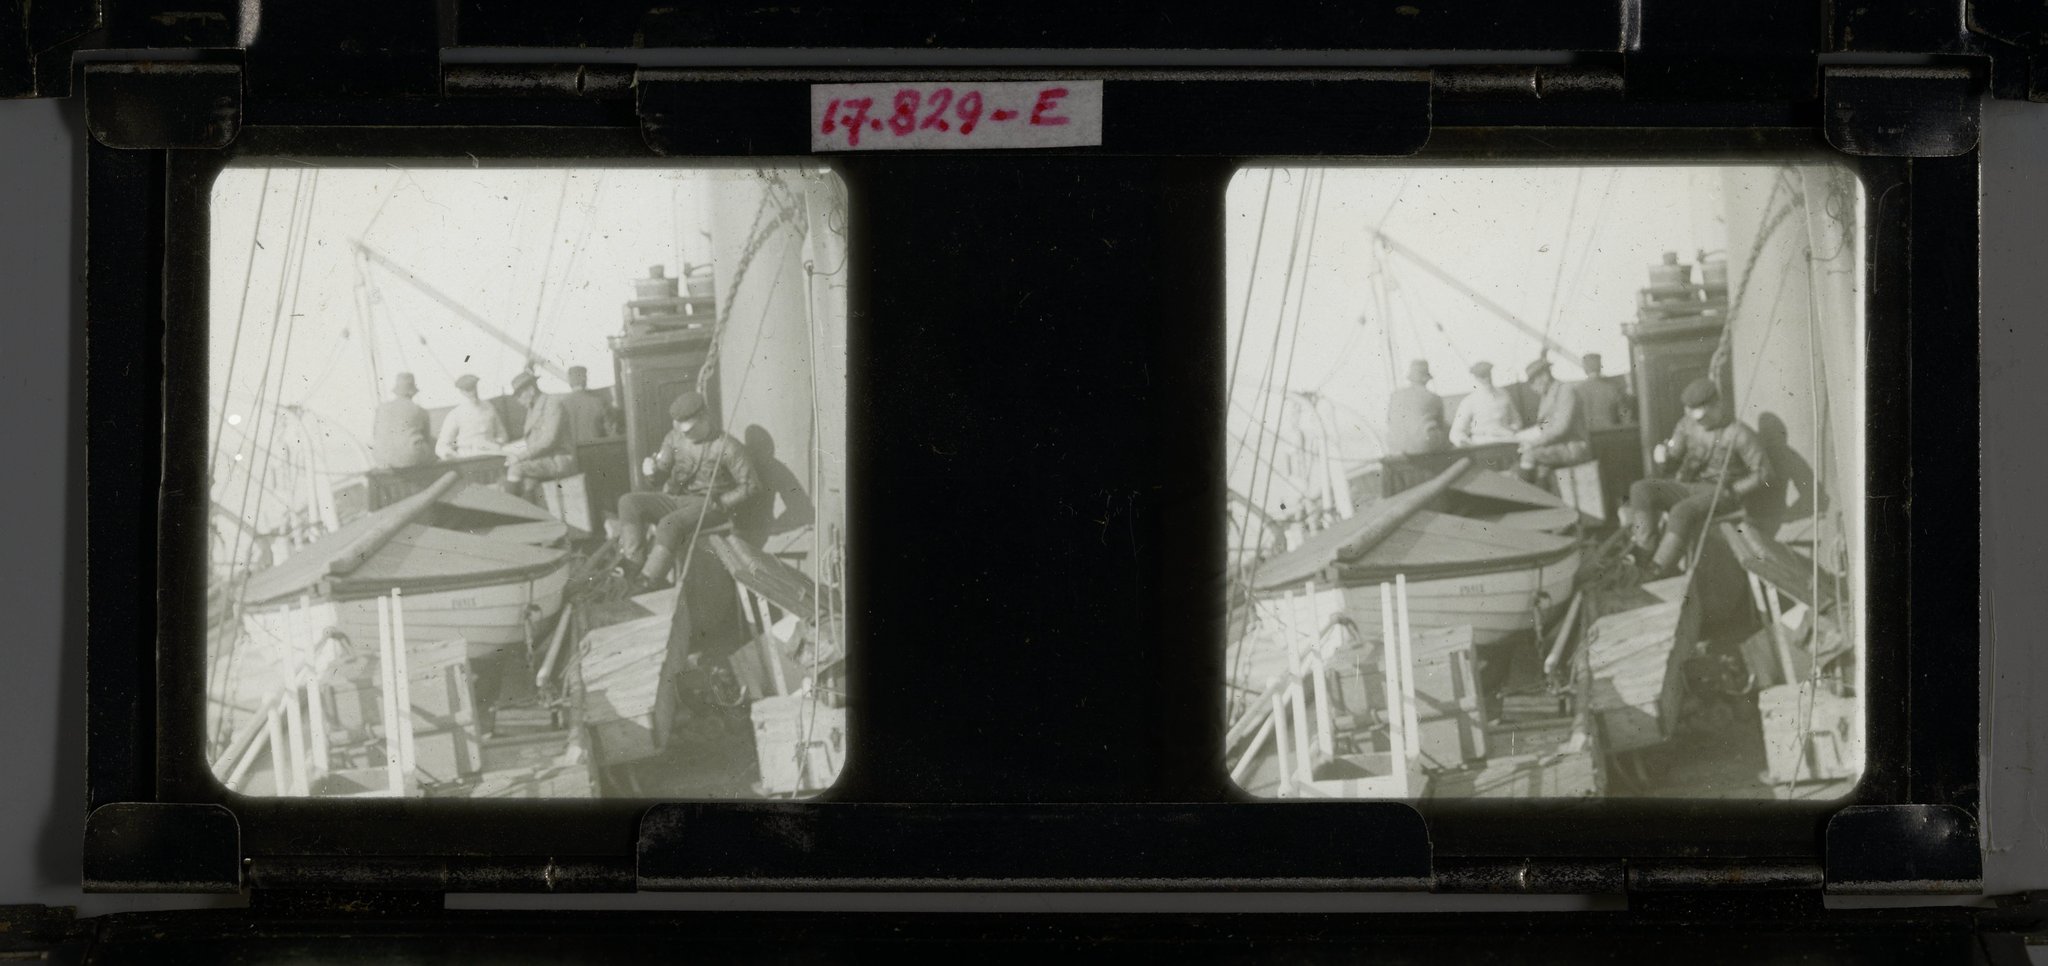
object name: stereoscopic photograph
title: Mannen zittend op het dek van het schip Fonix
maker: Anonymous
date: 1893-1923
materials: glass, metal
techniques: slide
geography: paris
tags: crew ~ ship